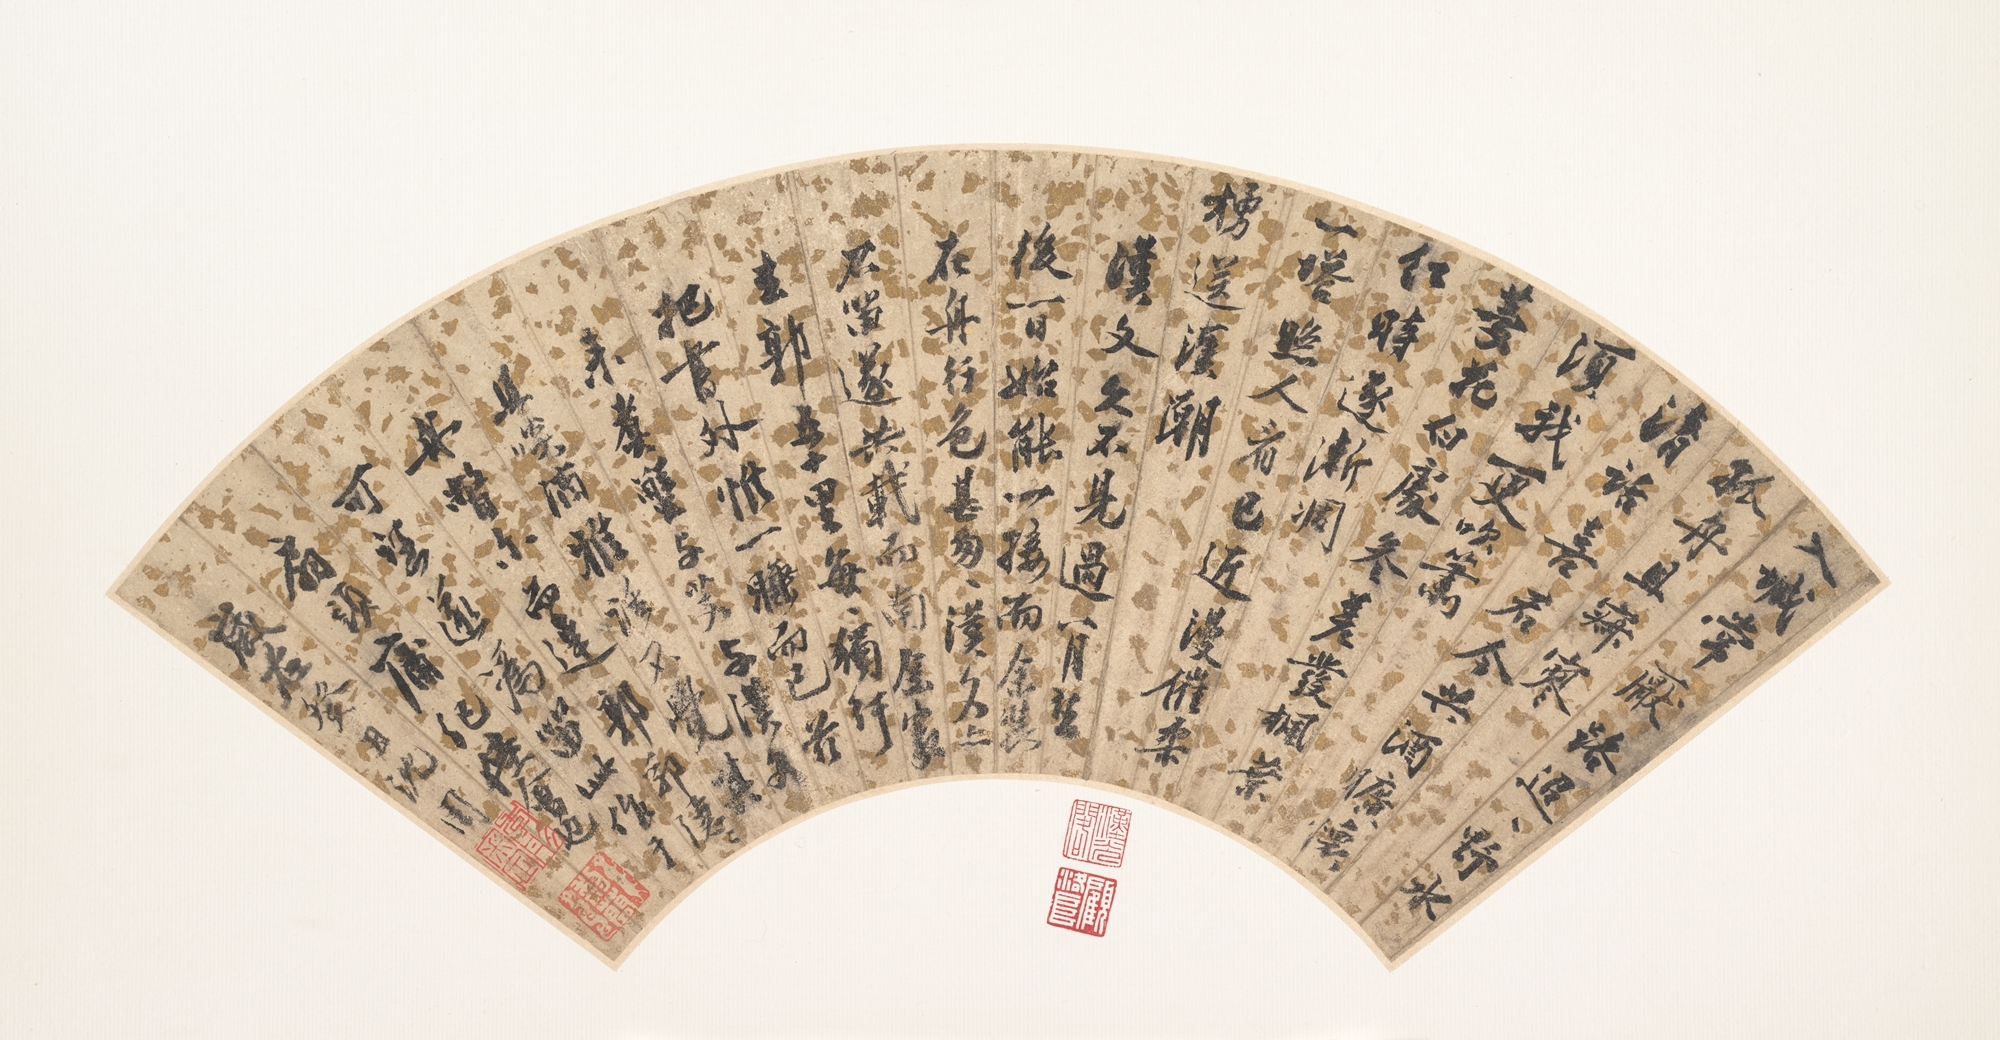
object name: folding fan mounted a an album leaf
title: Poem for Hanwen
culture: chinese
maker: shen zhou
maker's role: artist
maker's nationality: chinese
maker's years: 1427-1509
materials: gold, ink, paper